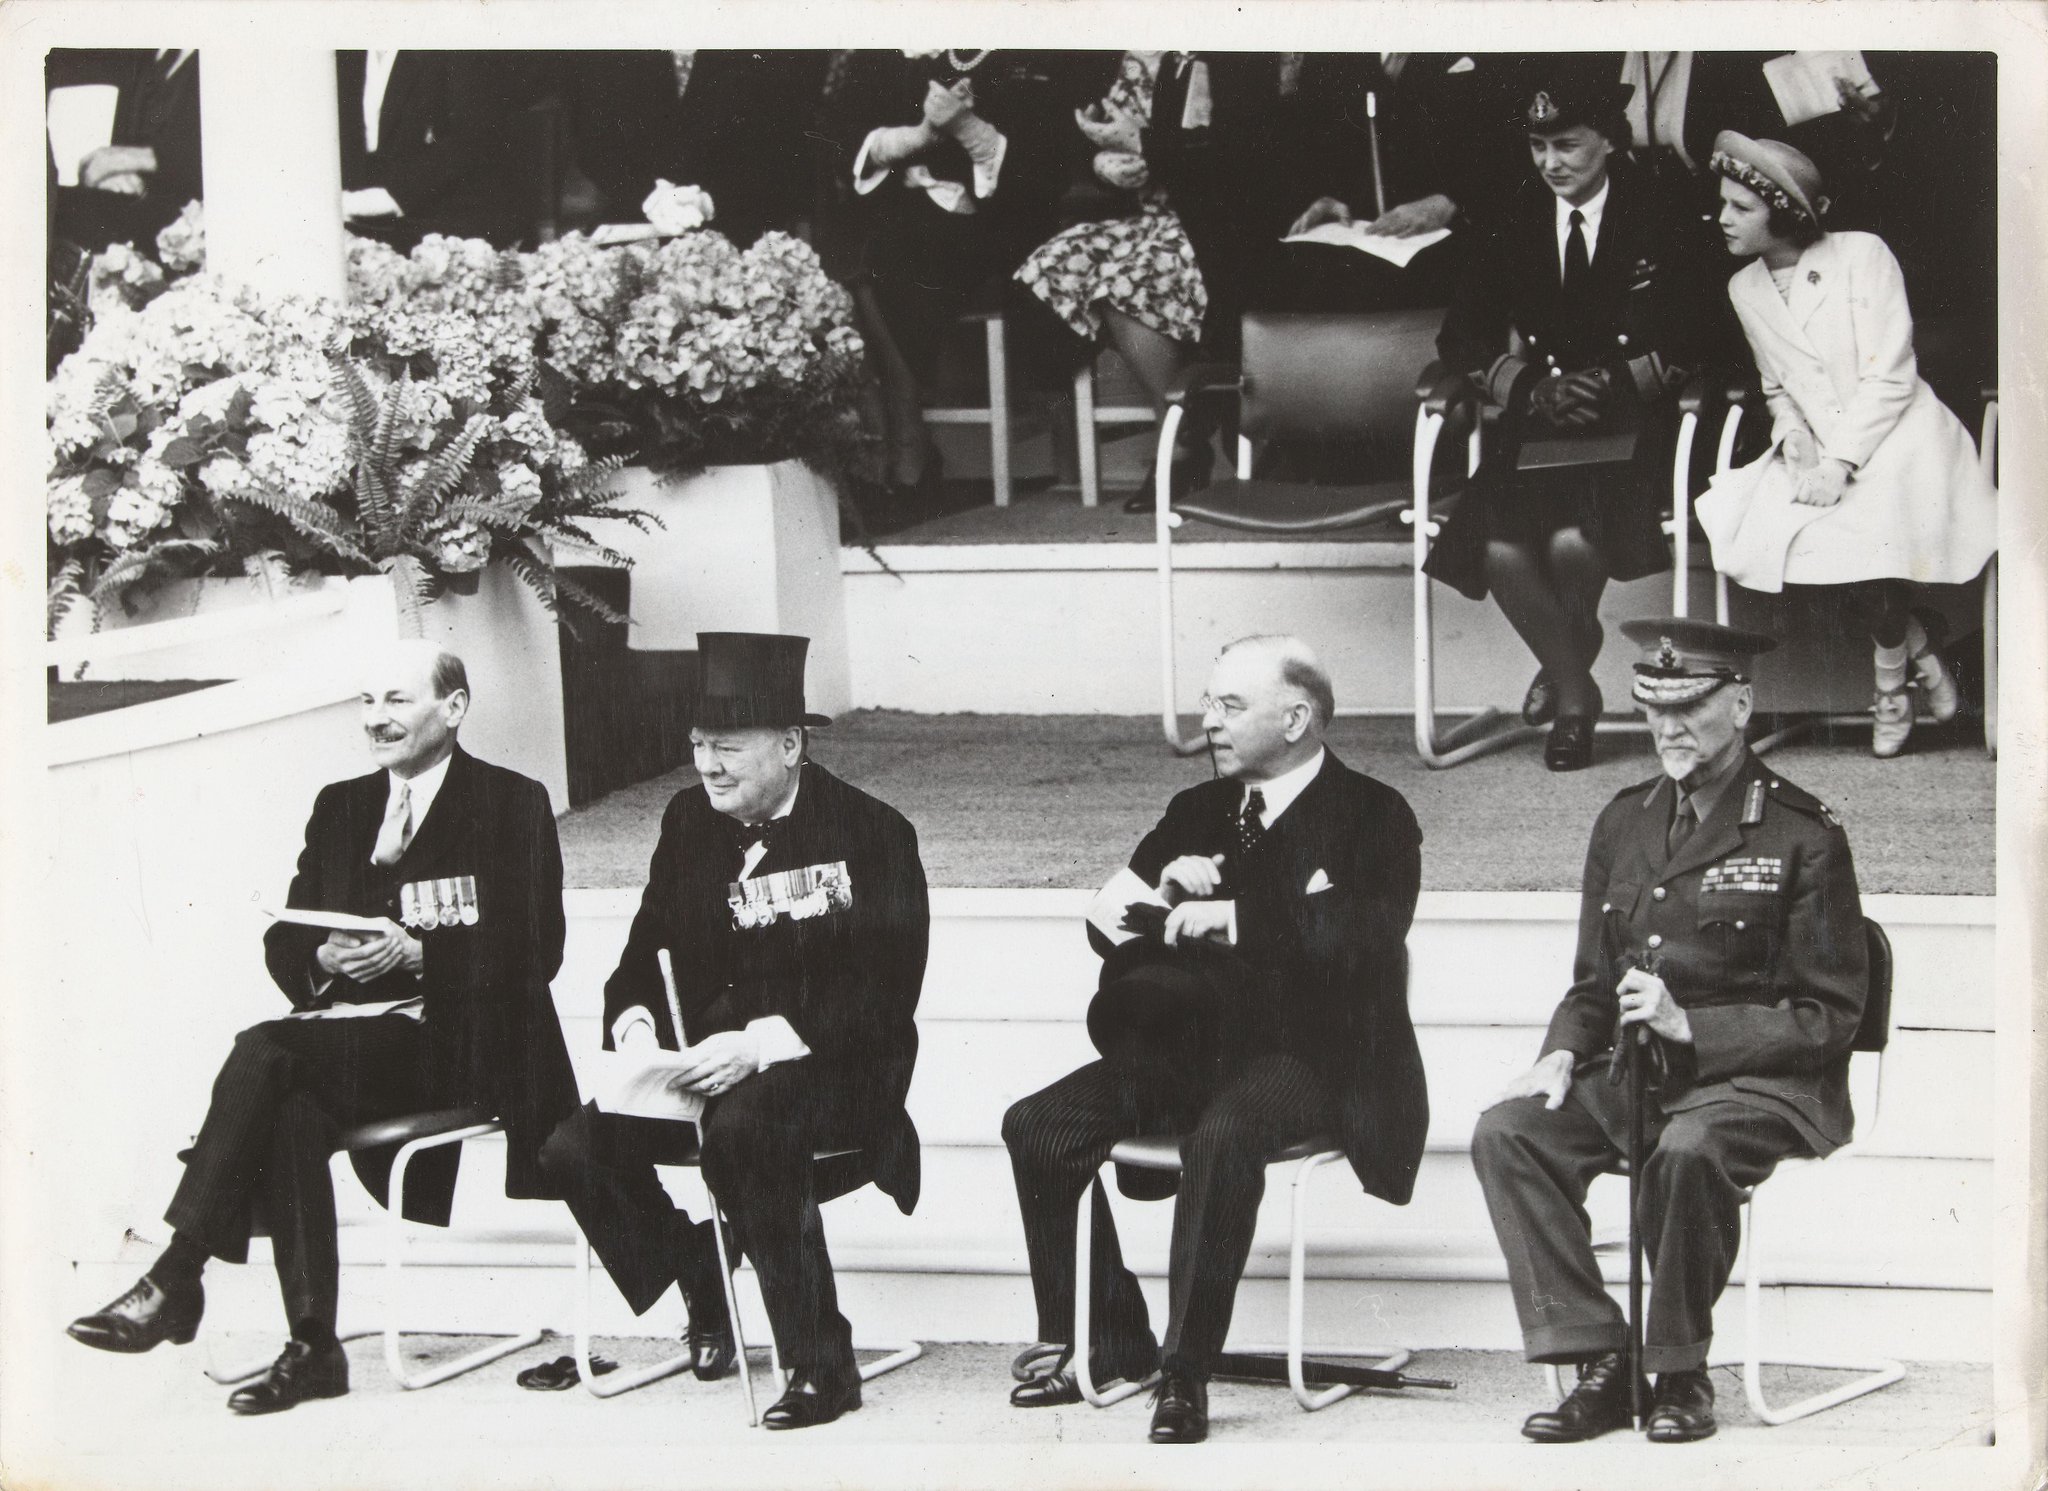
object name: photograph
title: W. Churchill bij parade op Victory Day, 8 juni 1946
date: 1946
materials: photographic support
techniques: gelatin silver print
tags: london